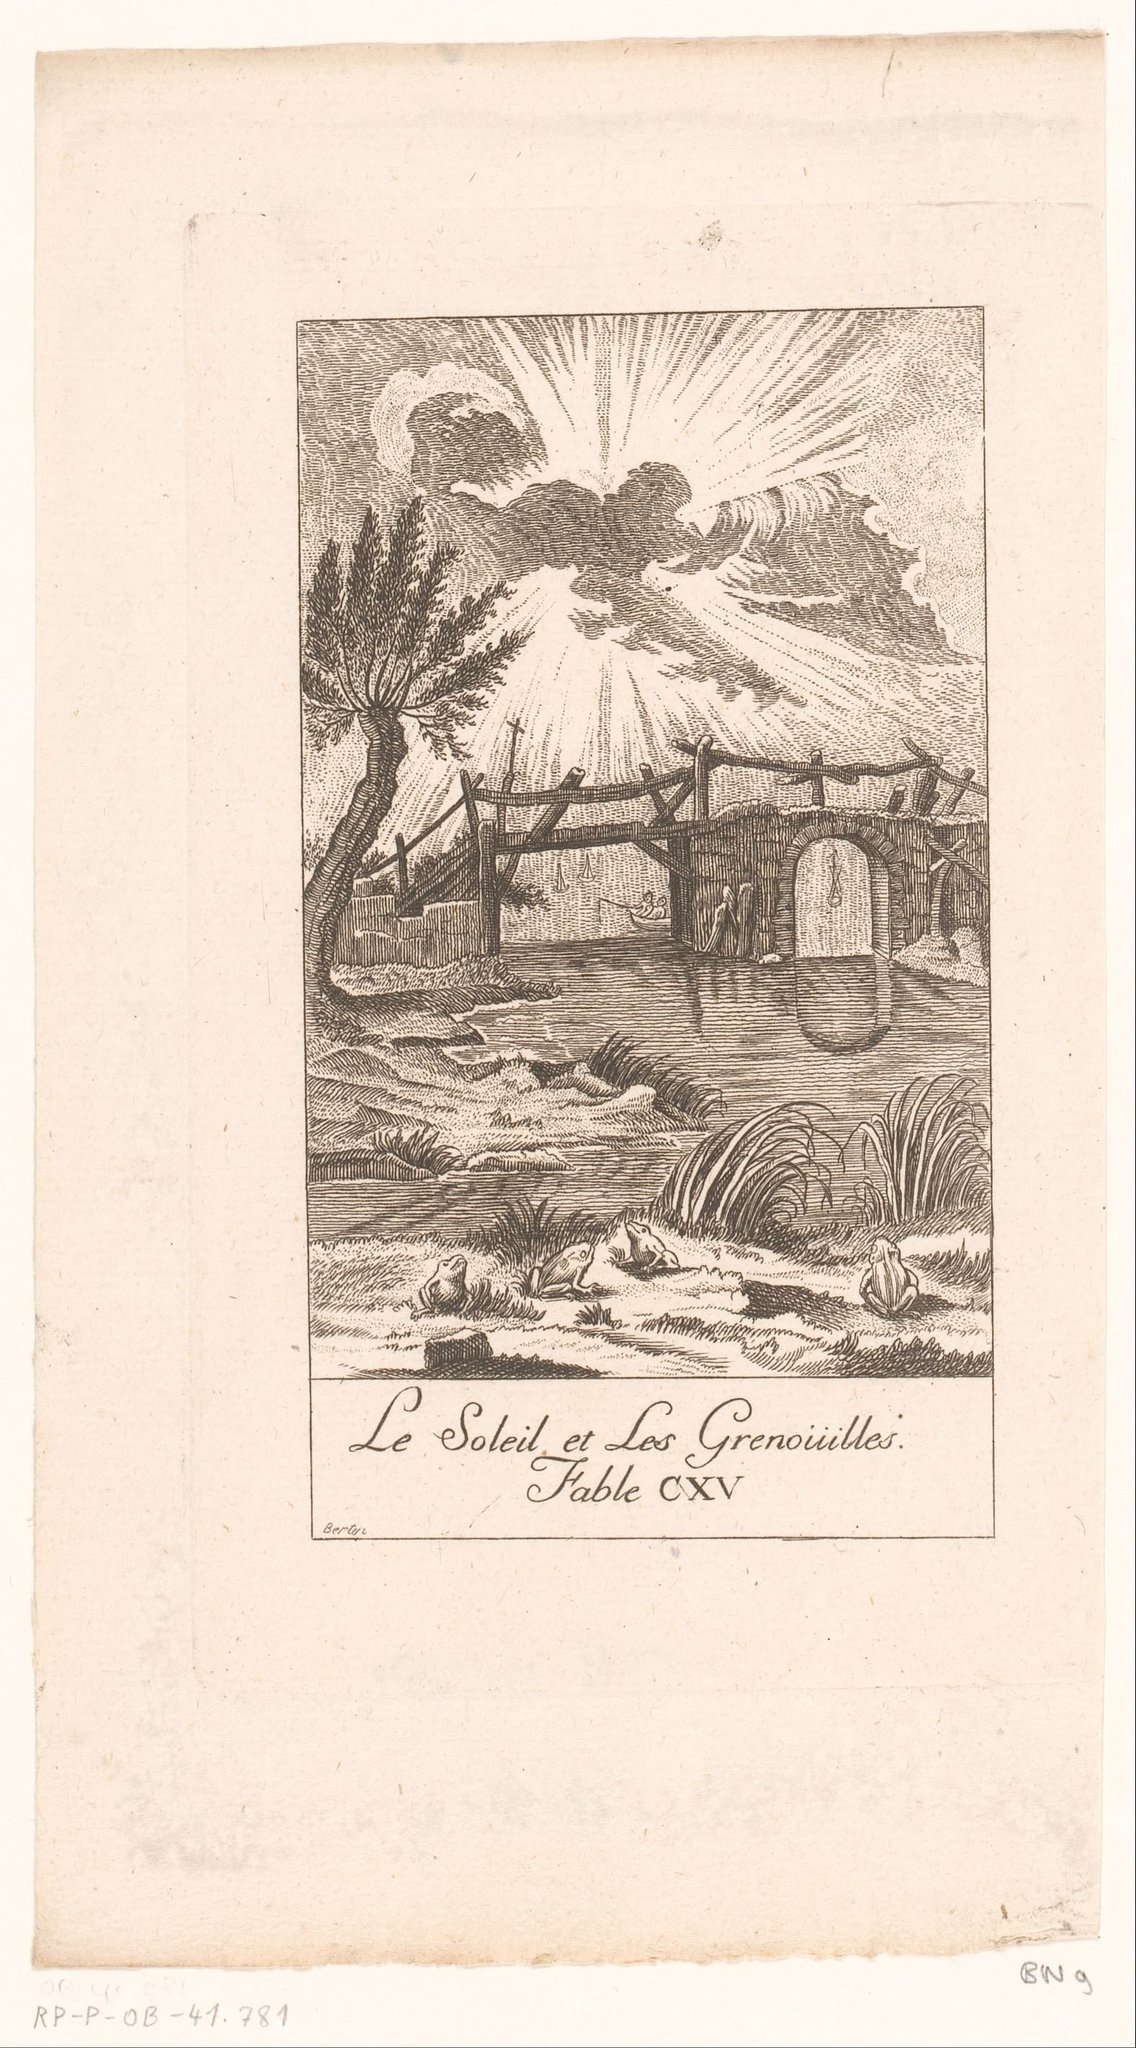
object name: print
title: Fabel van de zon en de kikkers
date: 1776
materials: paper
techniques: etching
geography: france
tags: tailless amphibians: frog, sun as celestial body, fables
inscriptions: collector's mark: Lugt 2228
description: Prent uit: Fontaine, Jean de la. Fables Choisies: Bouillon, Aux depens de la Société typographique. S.l.: s.d, 1776, dl. 2.